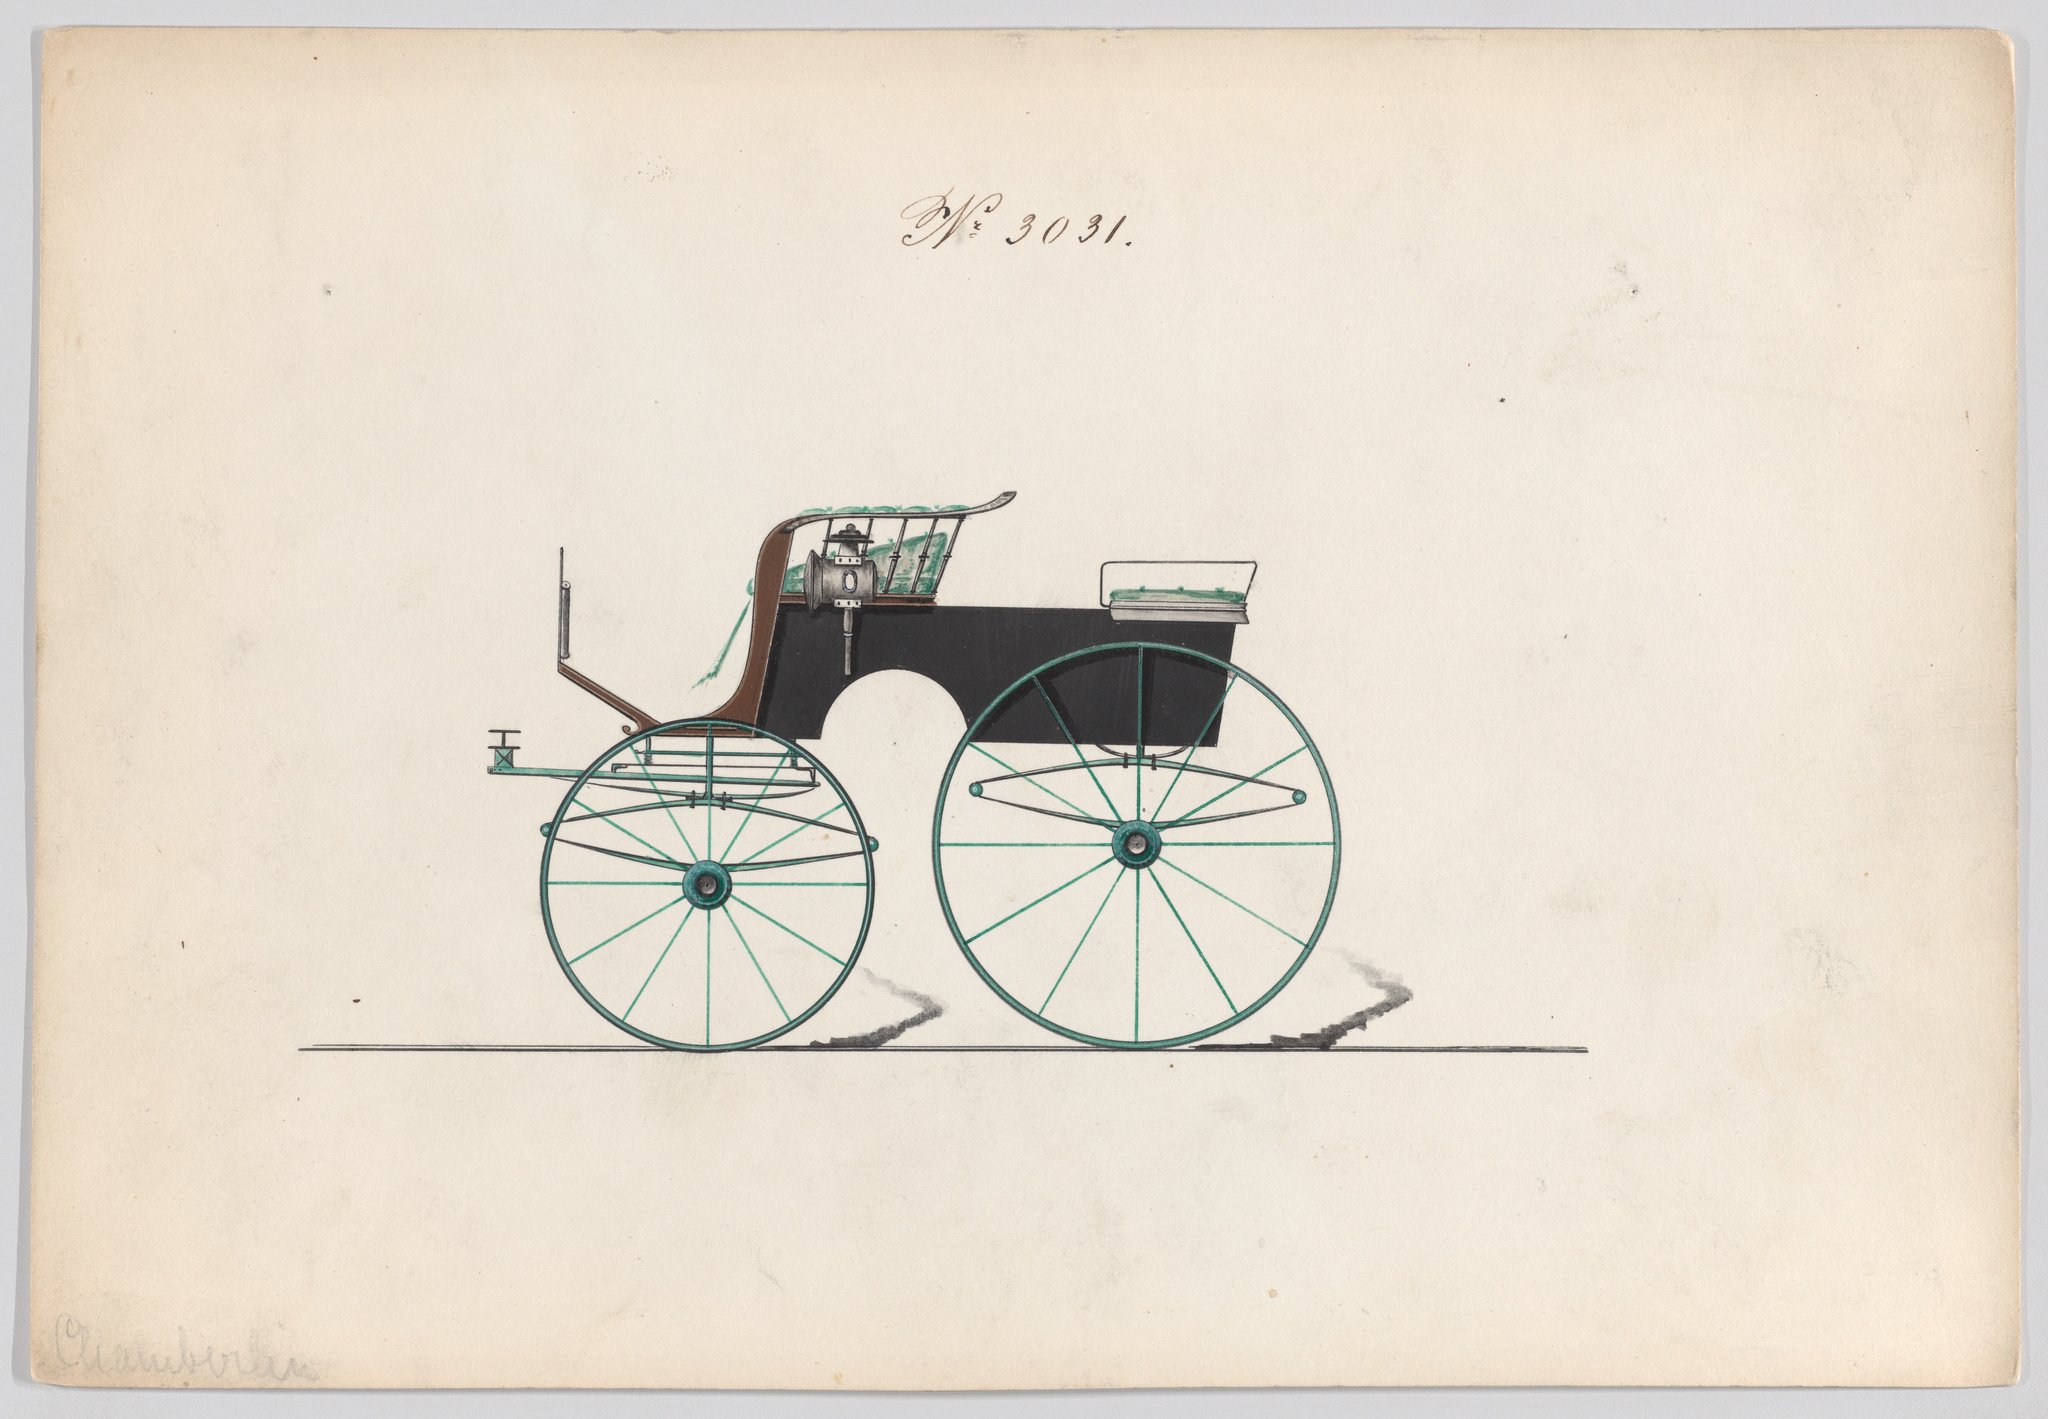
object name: drawing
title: Design for T-Cart, no. 3031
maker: brewster & co.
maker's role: manufacturer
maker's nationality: american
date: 1874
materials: gouache, gum arabic, ink, watercolor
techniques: pen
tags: carriages